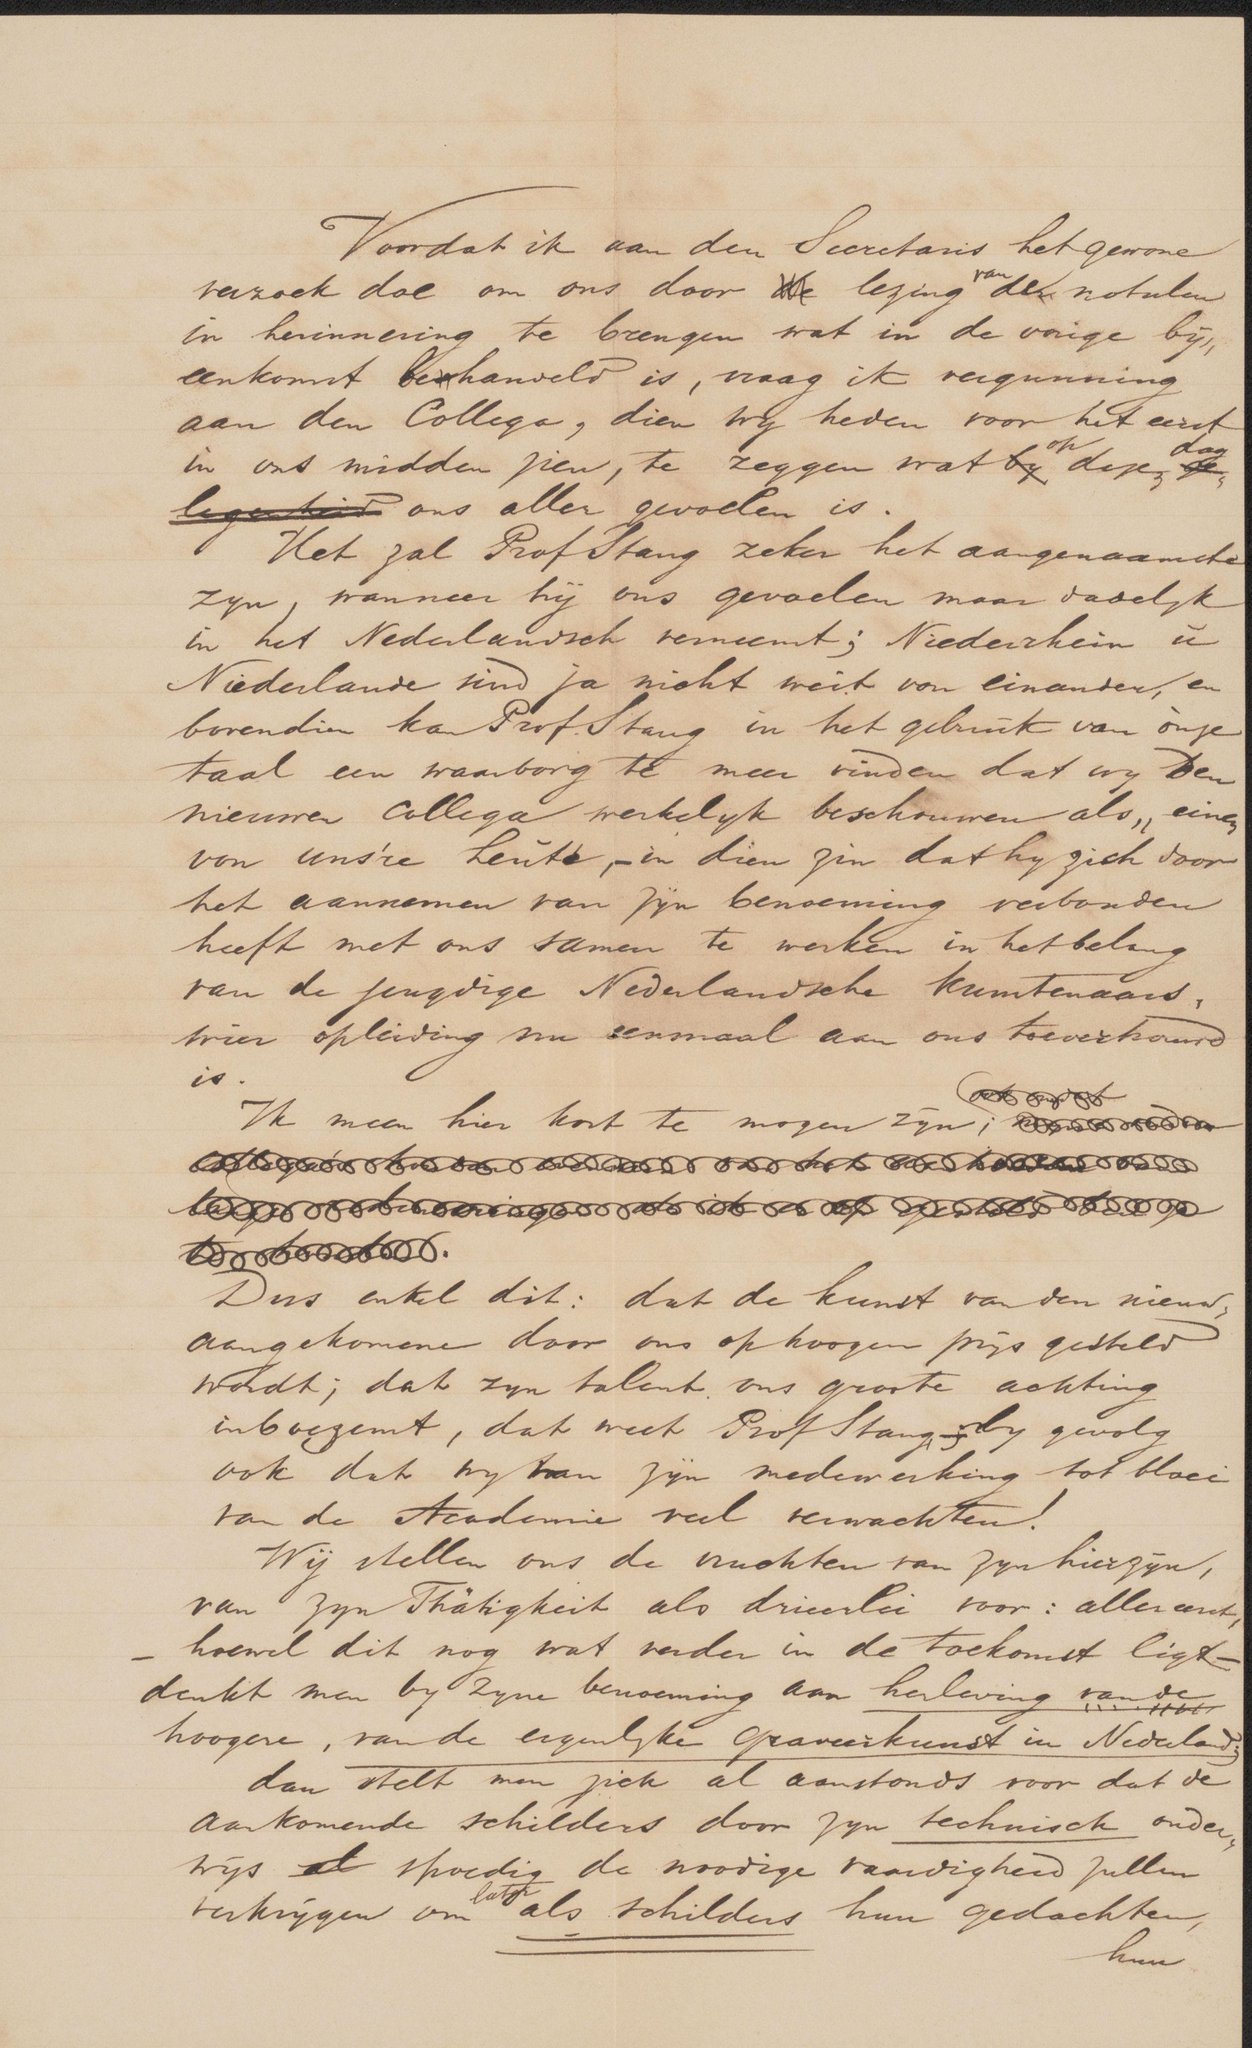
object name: tekst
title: Tekst uit collectie August Allebé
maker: Anonymous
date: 1884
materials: ink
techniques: pen, writing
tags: painter, print maker, draughtsman, rudolf stang, education, tuition of the artist (in general)